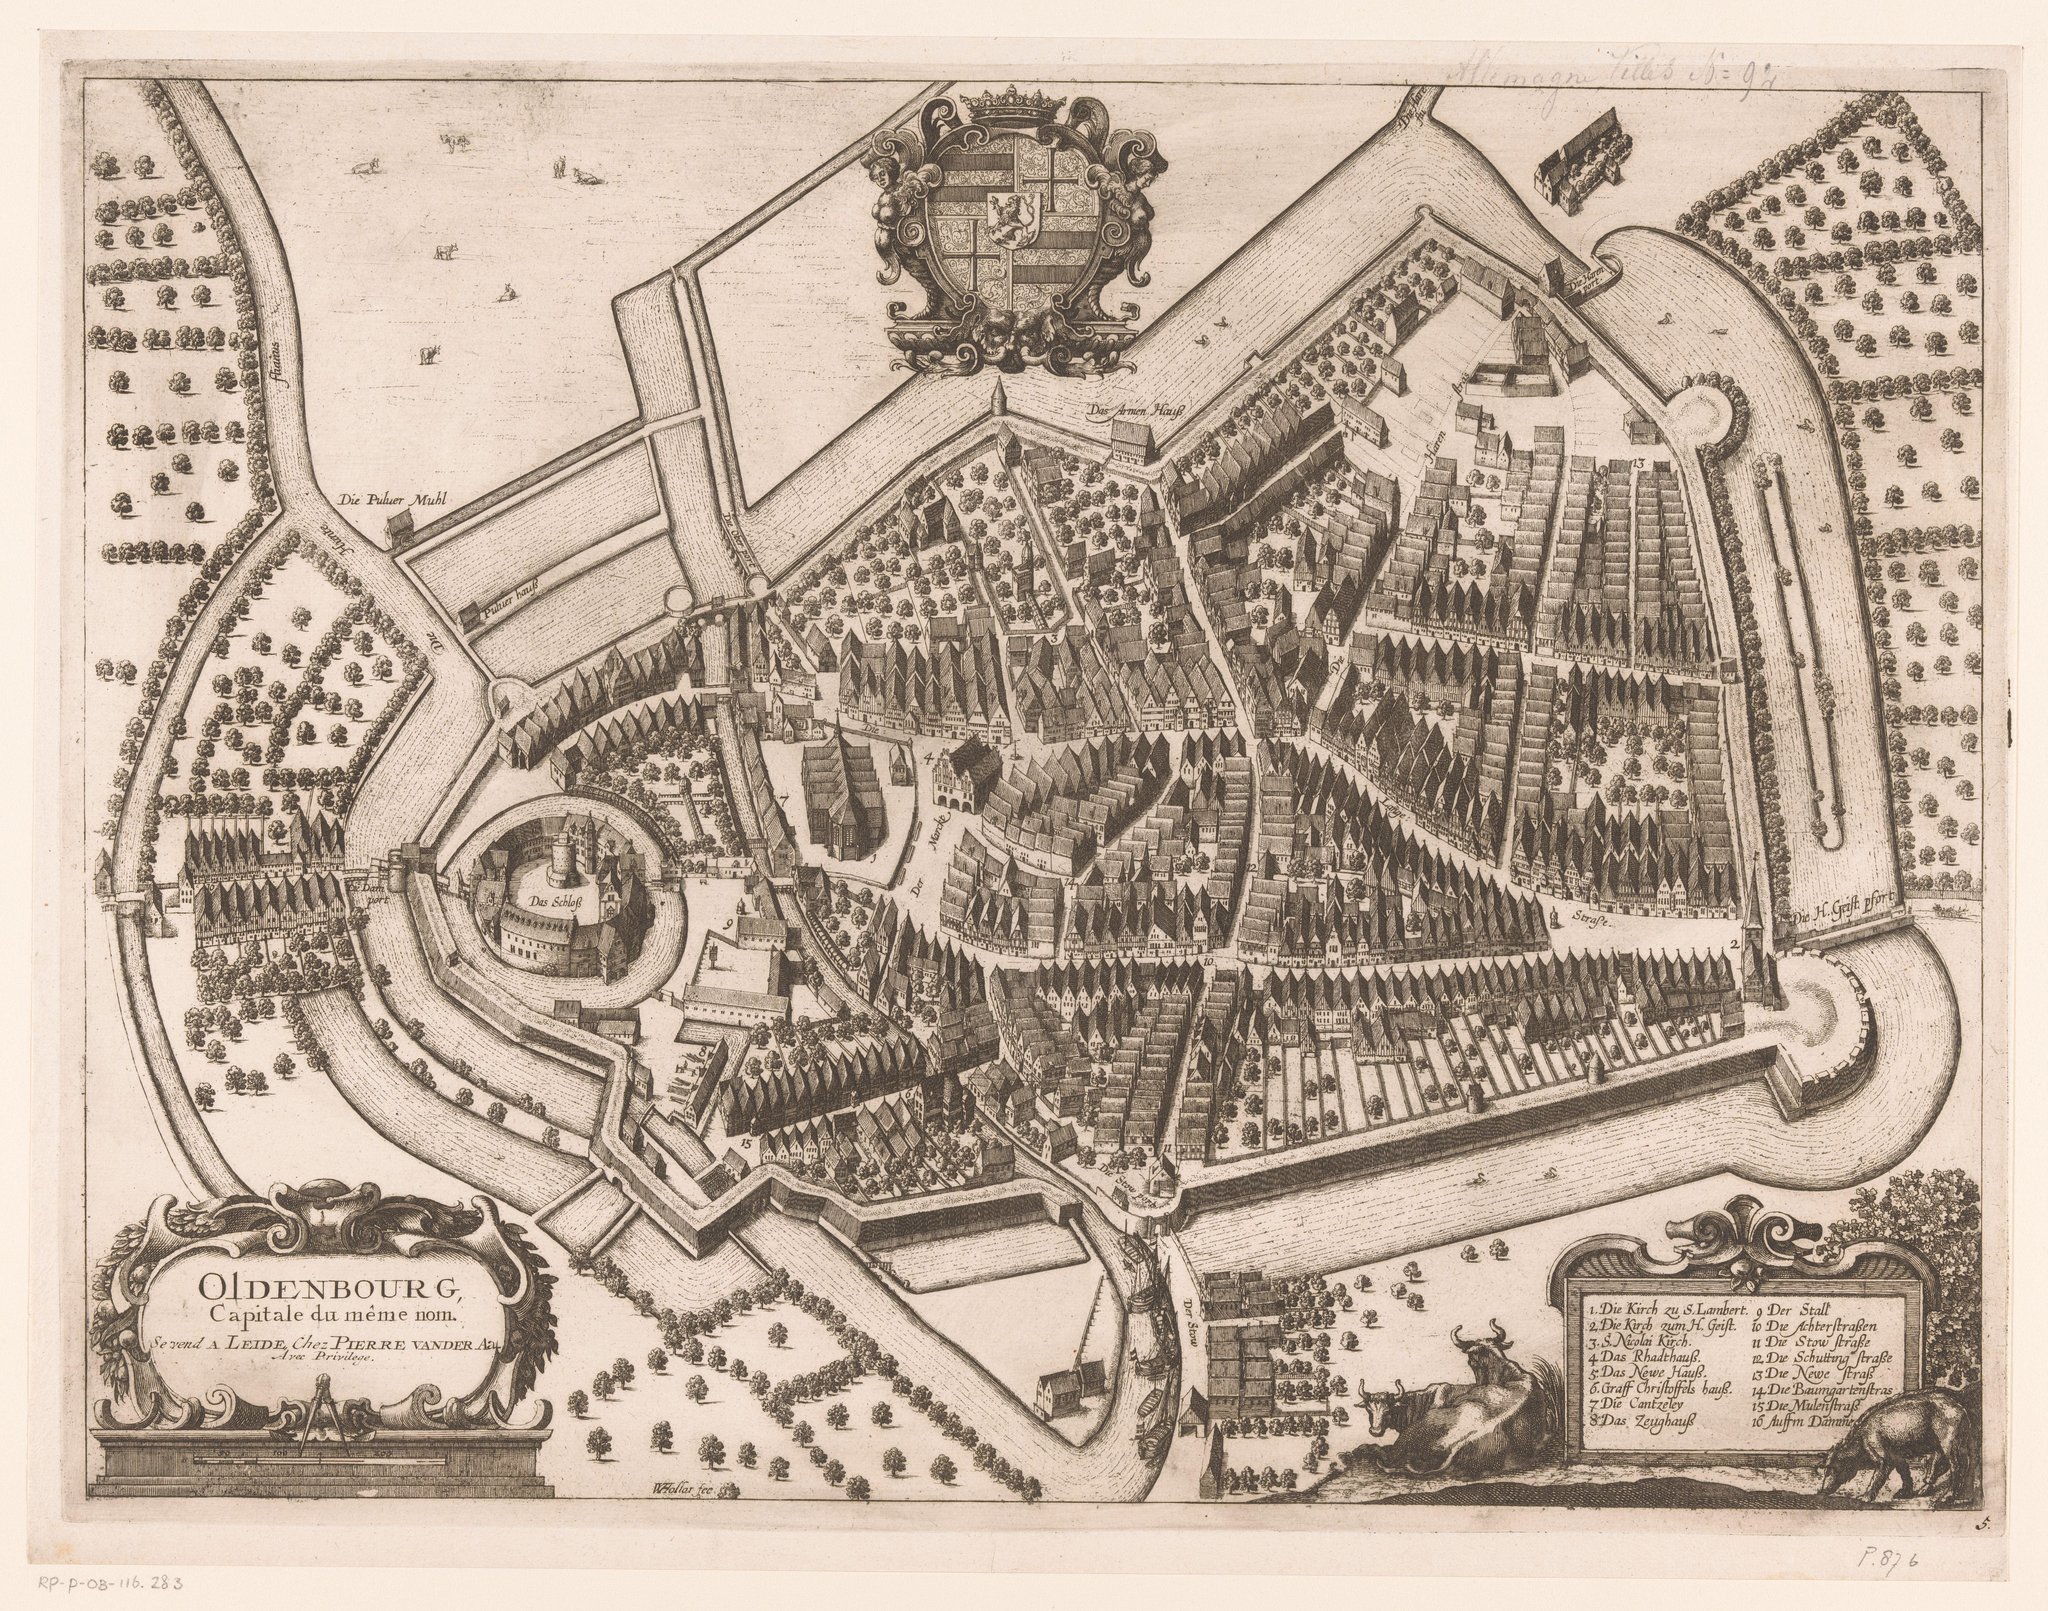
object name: print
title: Oldenbourg, Capitale du même nom. (...)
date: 1729-1733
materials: paper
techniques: etching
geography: germany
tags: fortified city, coat of arms (as symbol of the state, etc.) (+ province; provincial), prospect of city, town panorama, silhouette of city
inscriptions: collector's mark: Lugt 2228, annotation: ‘Allemagne (...)’, annotation: ‘5.’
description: Deze prent maakt deel uit van een serie van 500 prenten. Prent gebruikt in: Civitates orbis terrarum. Urbium totius Germaniae superioris. Amsterdam: Johannes Janssonius, 1657, dl. 3-4. Deze prent is gebruikt in: La Galerie Agréable du Monde. Leiden: Pieter van der Aa, 1729.